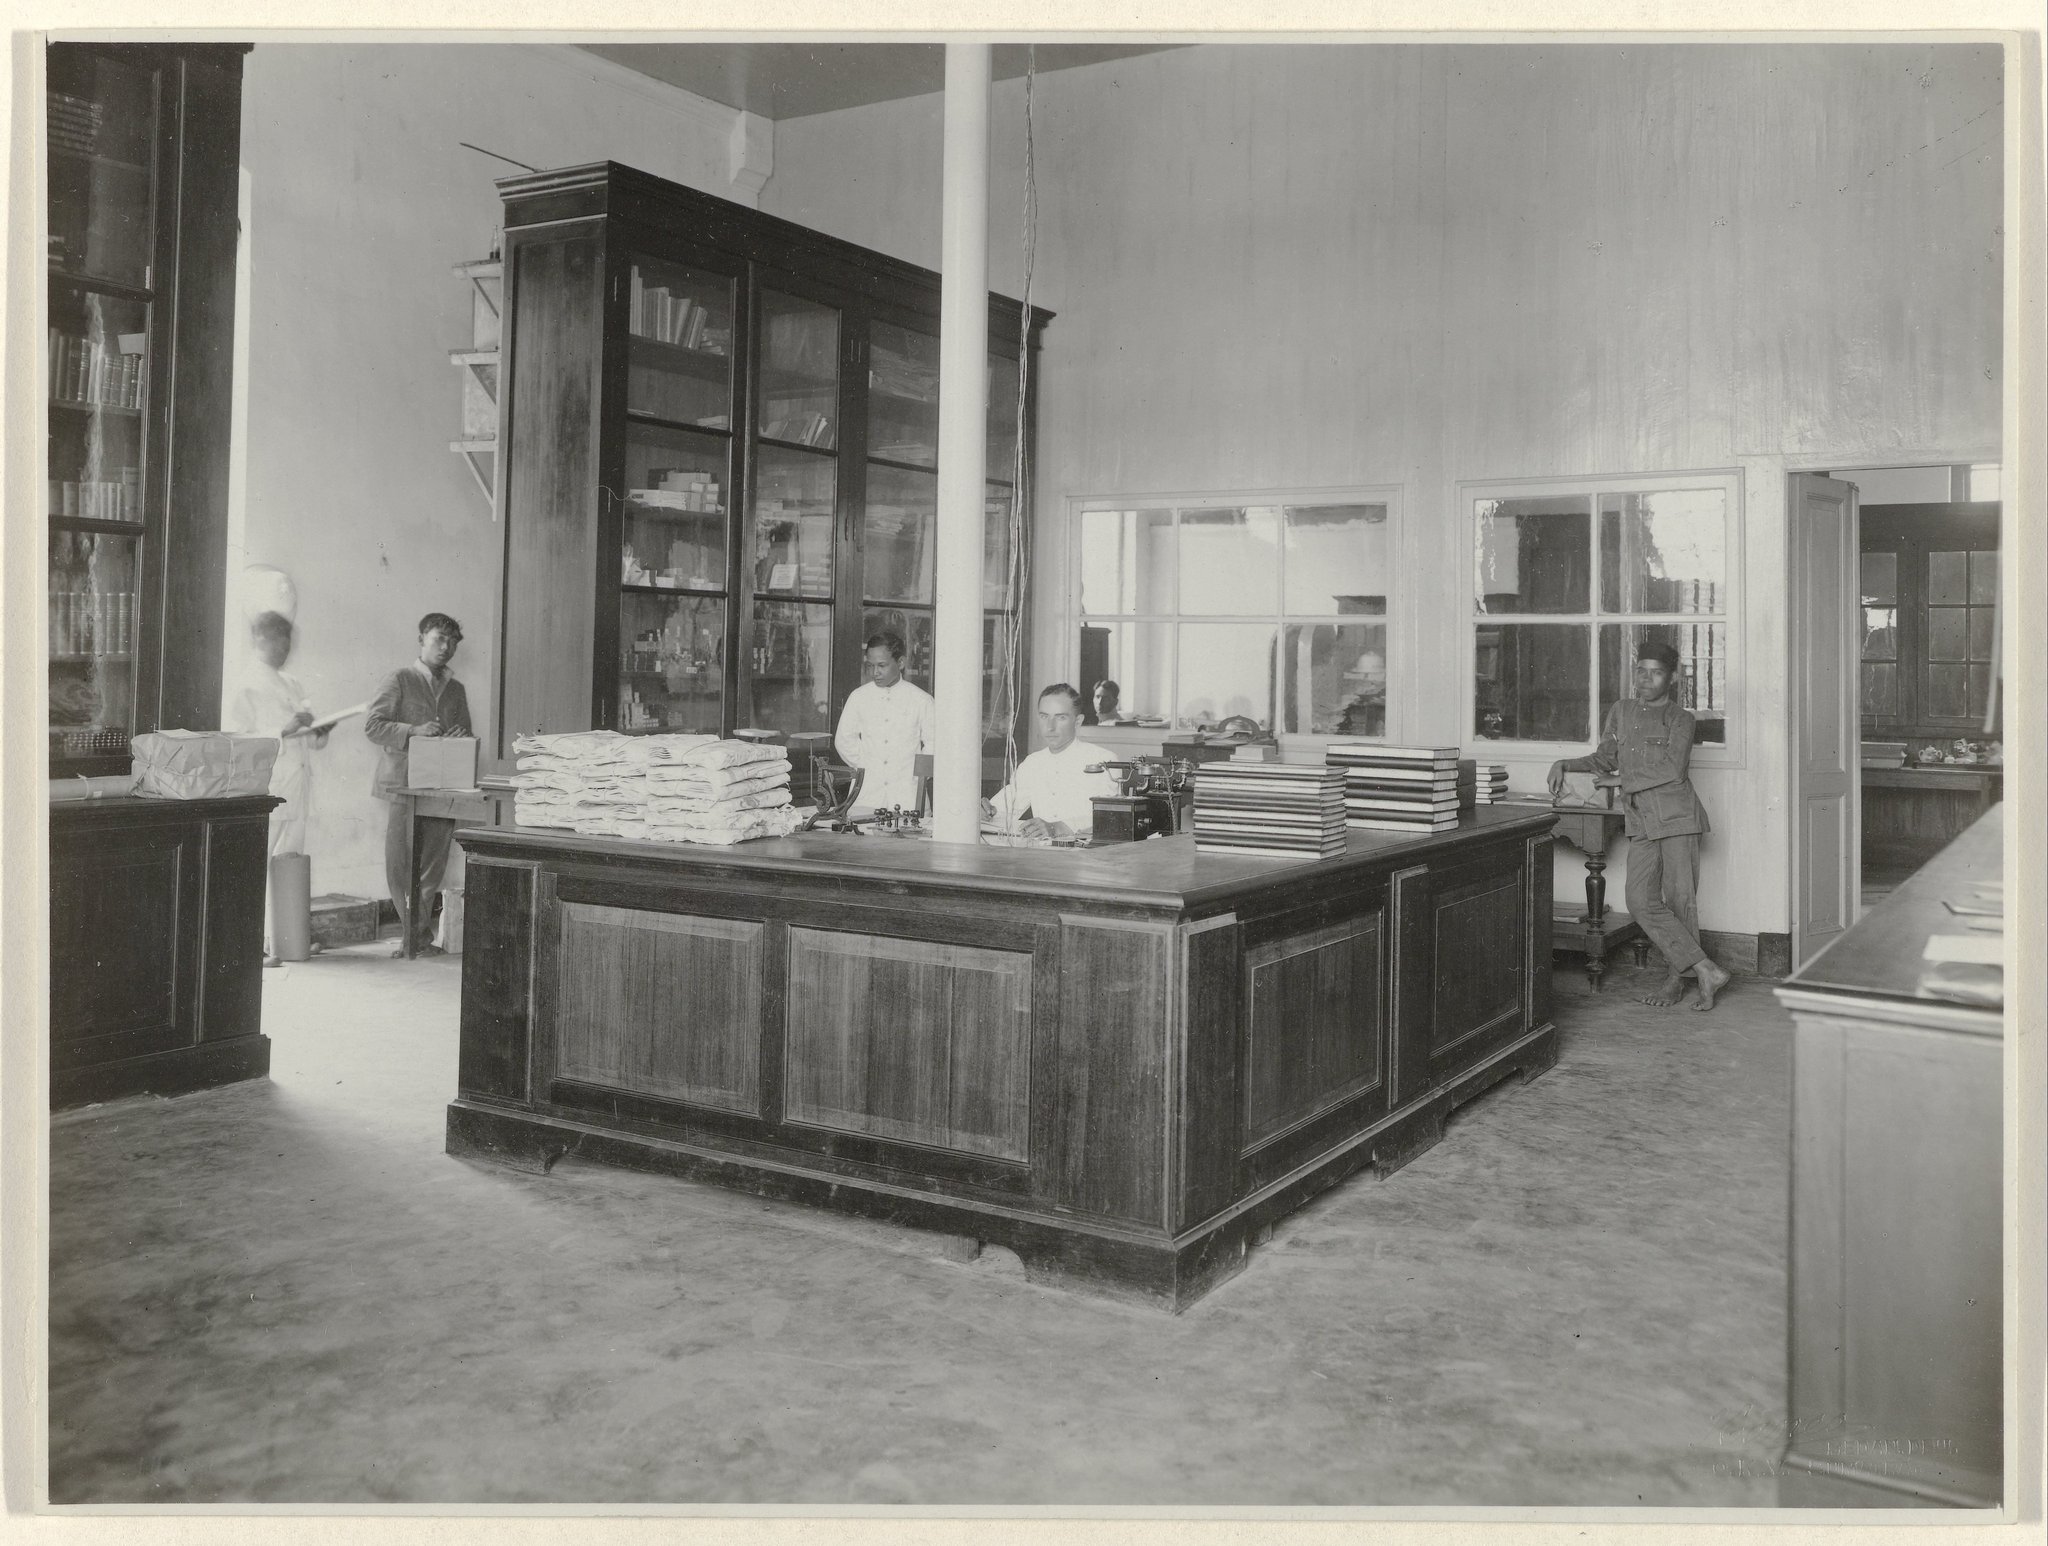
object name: photograph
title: Kantoor expeditie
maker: t. kaneo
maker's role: fotograaf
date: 1921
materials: photographic support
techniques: gelatin silver print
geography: medan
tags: dutch east indies, the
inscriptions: inscription: ‘Expeditie’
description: Het kantoor van de expeditie op de drukkerij van de Deli Courant in Medan. Onderdeel van een groep van 18 foto's uit 1921 binnen de groep van 49 losse zwart-wit foto's van verschillend formaat over de uitgeverij en drukkerij van de krant Deli Courant in Medan in de periode 1885-1947.